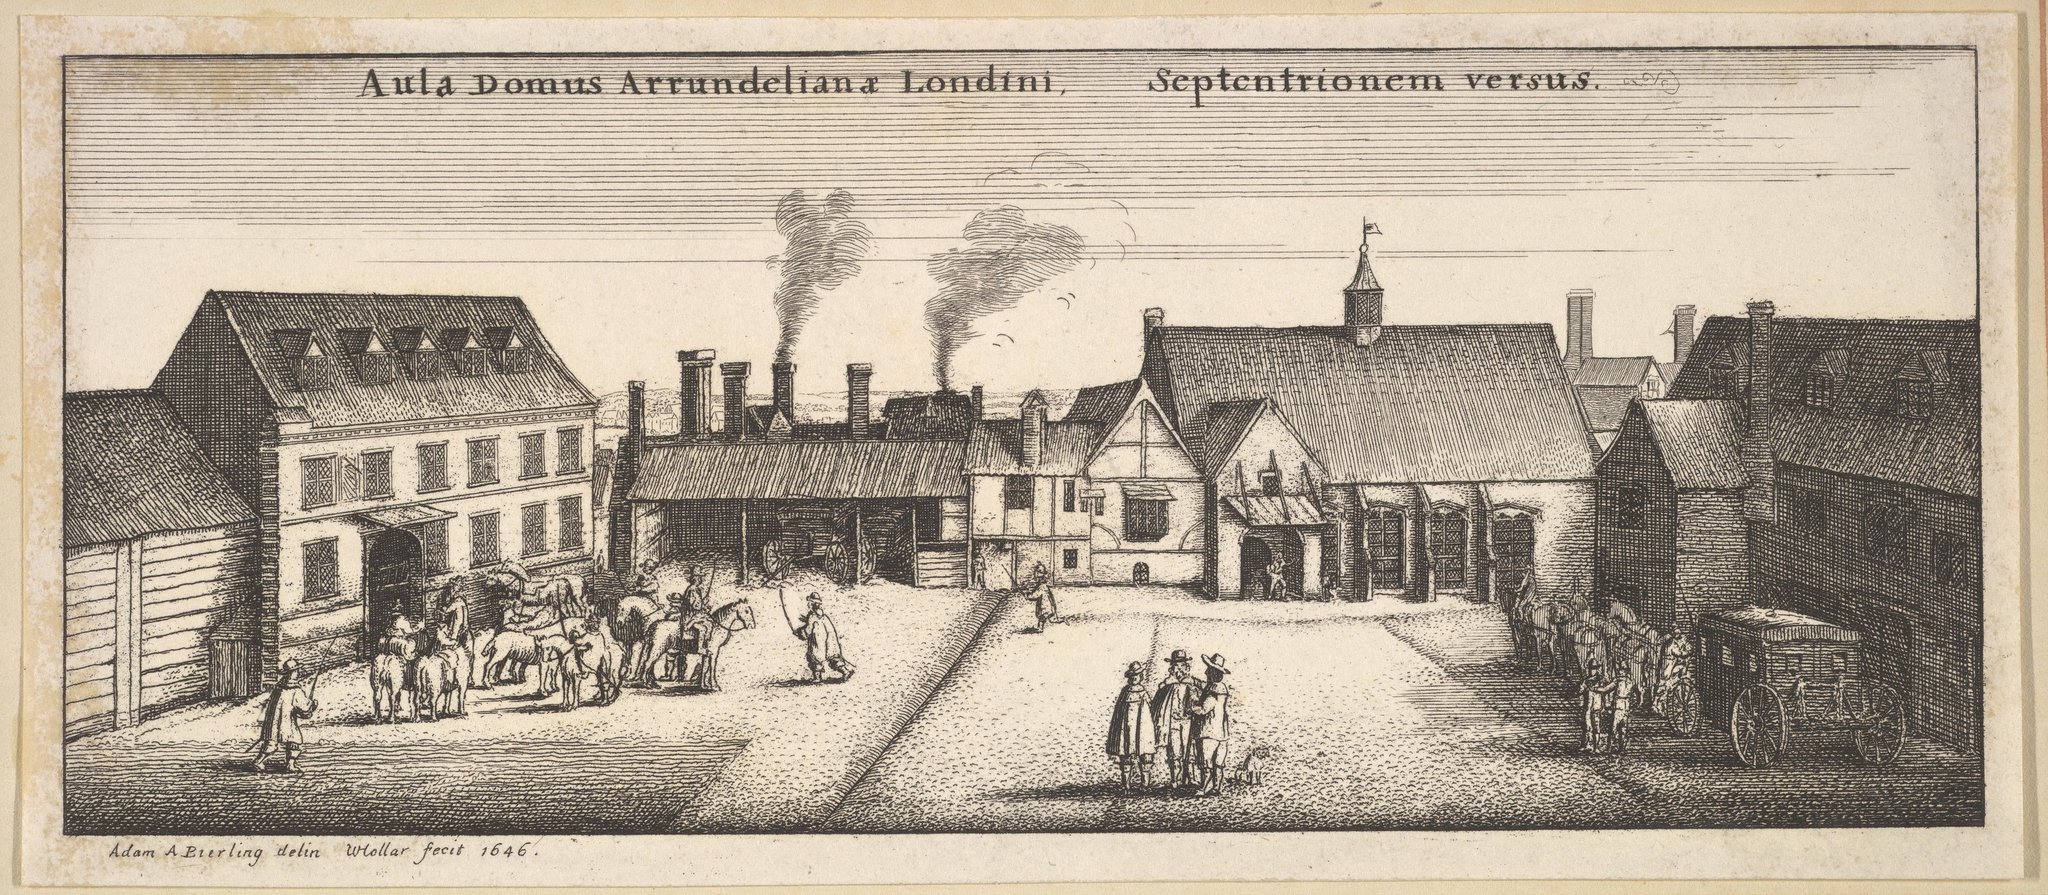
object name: print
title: Arundel House from the North (copy)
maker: wenceslaus hollar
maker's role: artist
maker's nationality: bohemian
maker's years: 1607-1677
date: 1601-1700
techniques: etching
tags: human figures,houses,horses,carriages